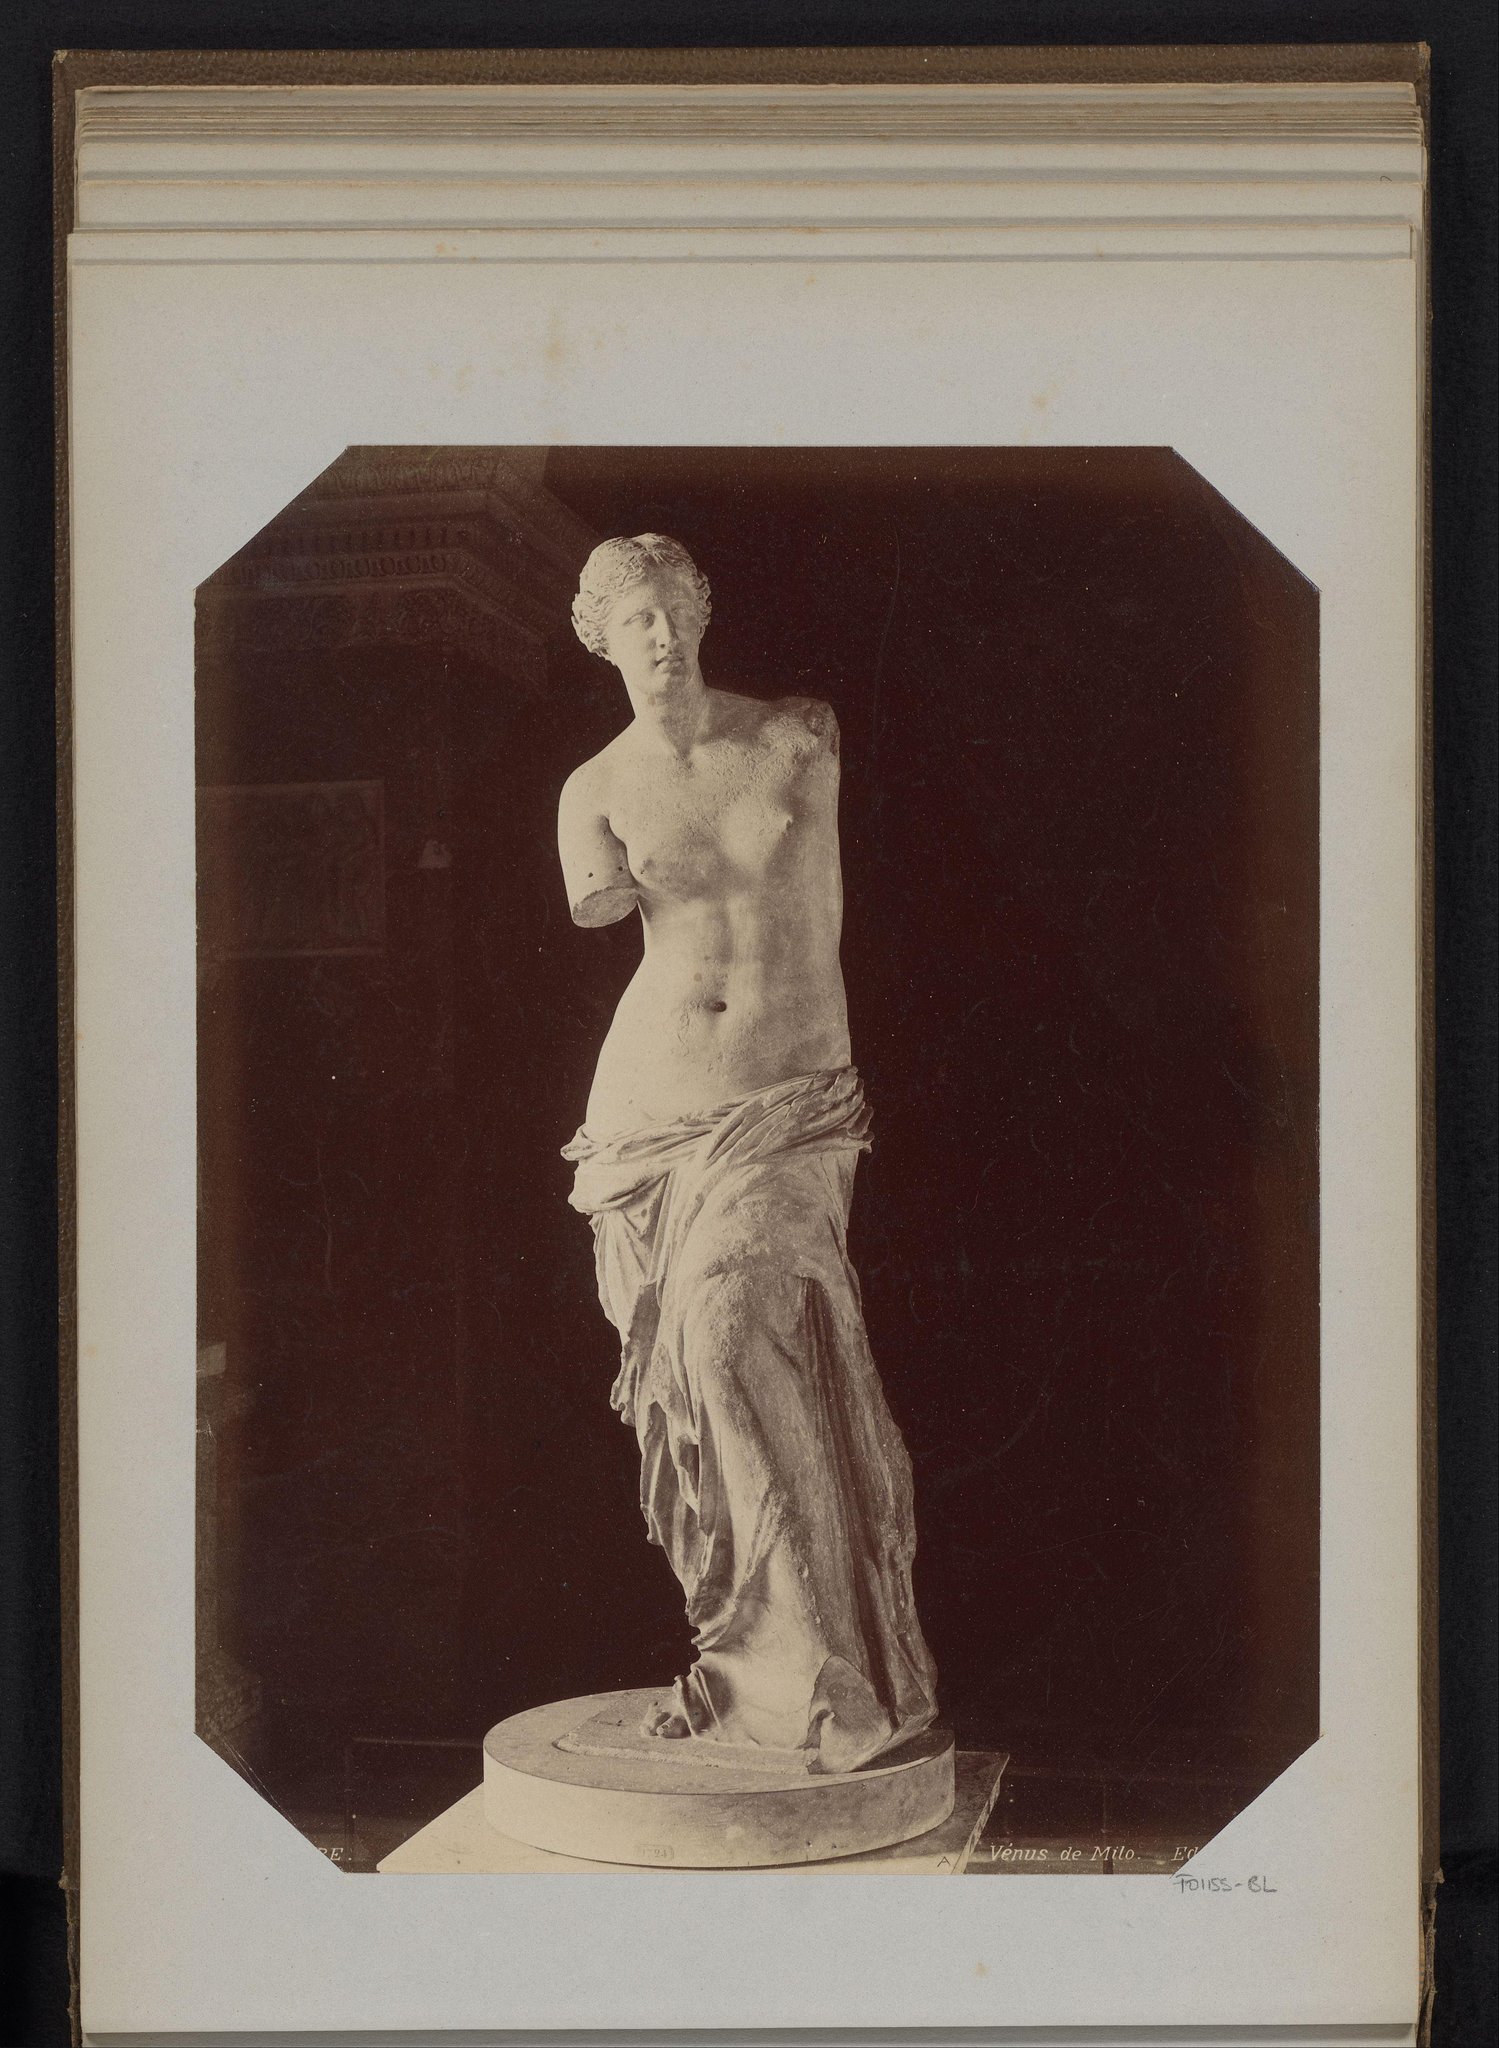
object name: album leaf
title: Venus van Milo in het Musée du Louvre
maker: edouard hautecoer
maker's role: publisher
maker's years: 1847-1904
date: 1890-1898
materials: photographic support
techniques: albumen print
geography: paris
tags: sculpture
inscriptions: inscription: ‘610A LOUVRE. Vénus de Milo. Ed. H. édit. phot.’, retailer's mark: ‘E. Hautecoeur/ Estampes Photographies/ 35 Avenue de l'Opéra, 35/ Paris’